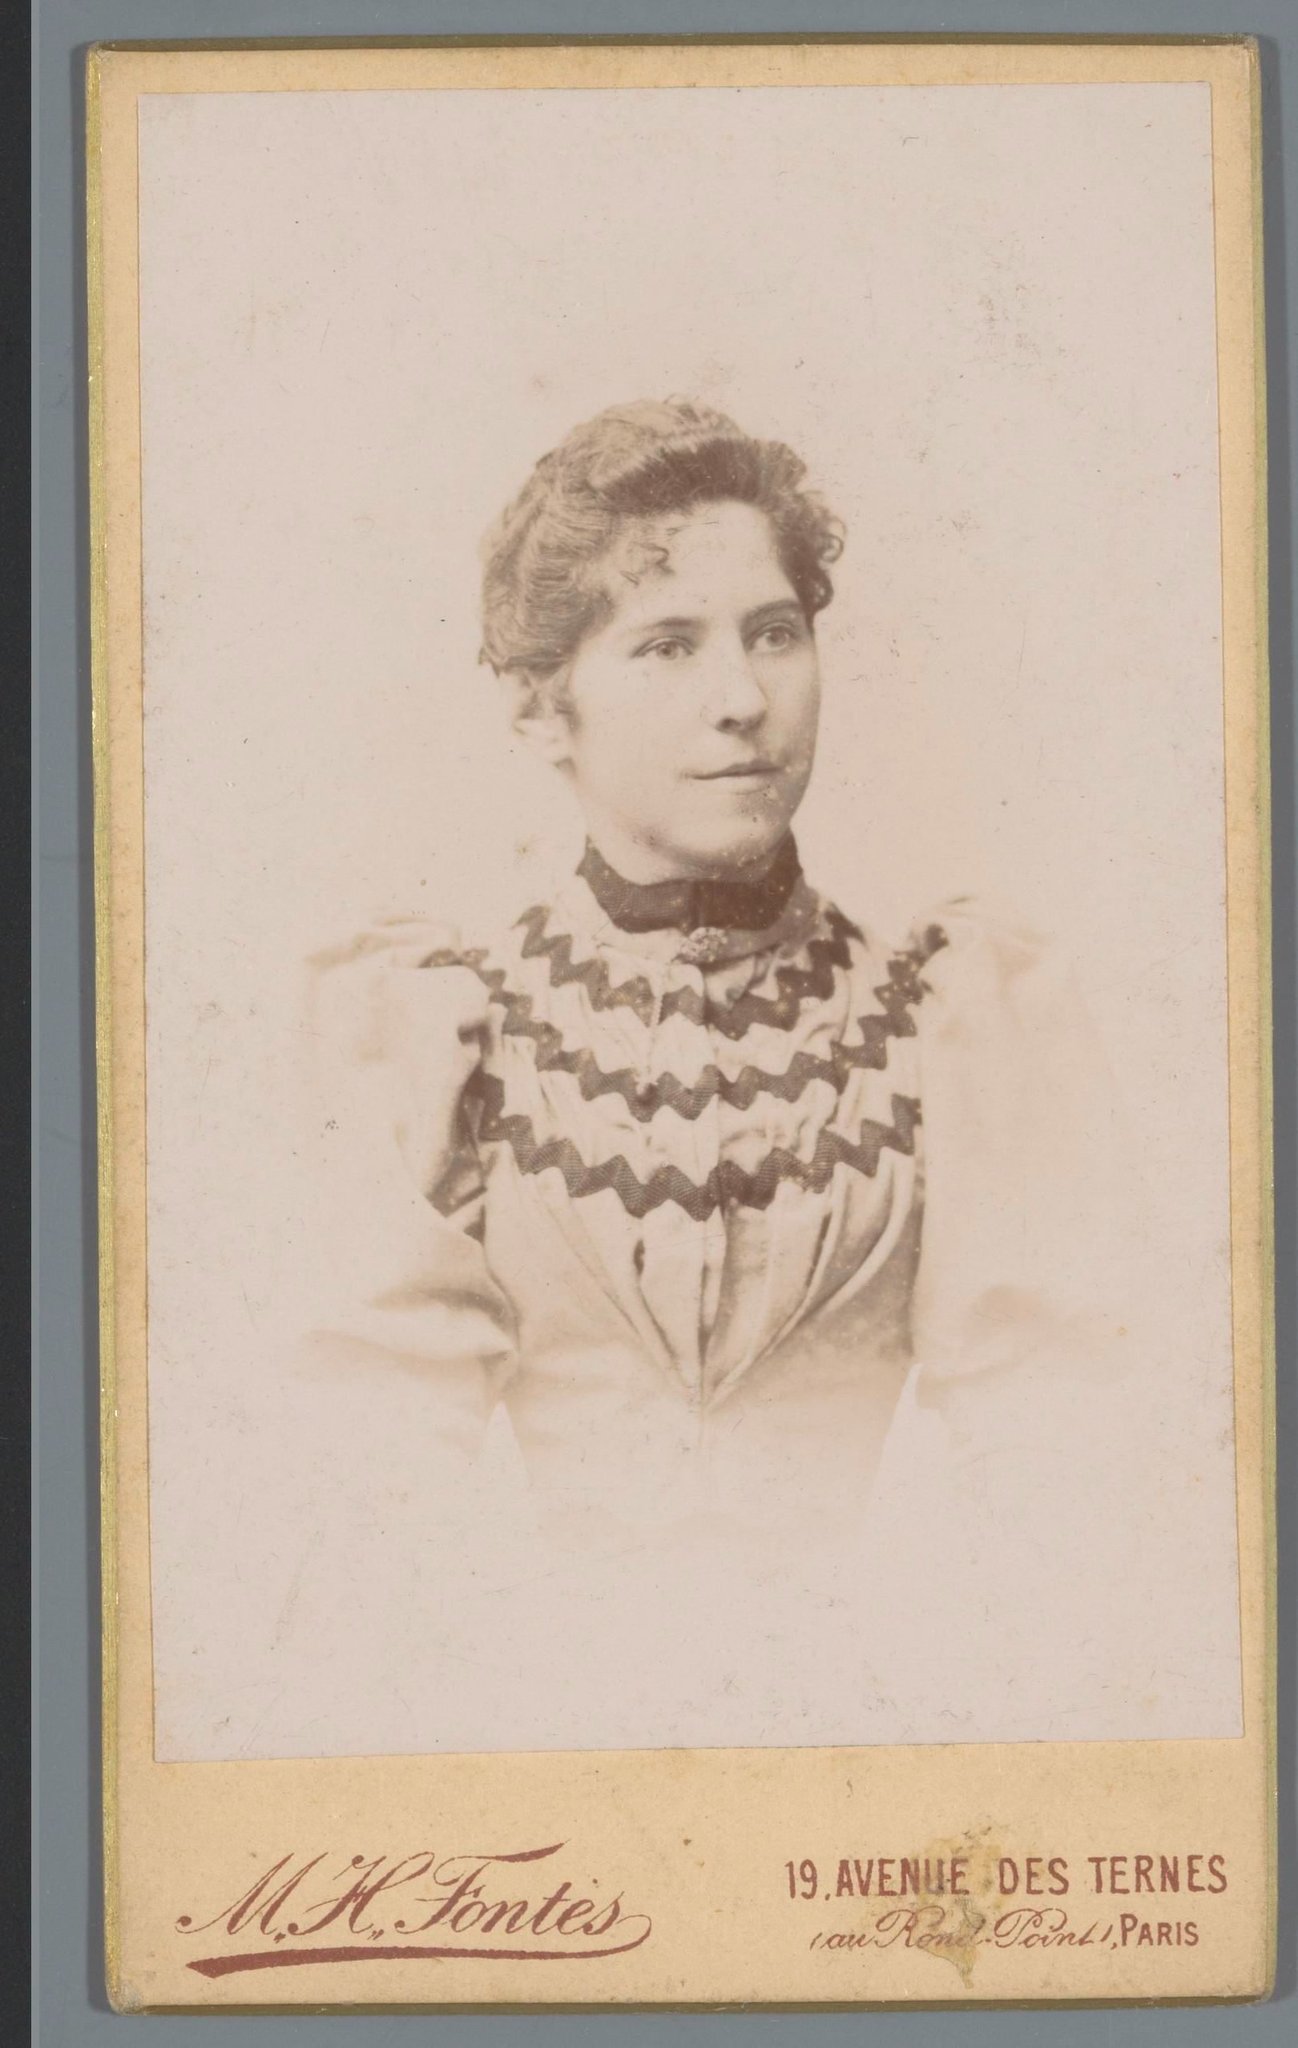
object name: carte de visite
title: Portret van een onbekende vrouw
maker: m.h. fontès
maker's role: fotograaf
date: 1875-1890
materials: paper, cardboard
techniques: collodion silver print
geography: paris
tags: adult woman, anonymous historical person portrayed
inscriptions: address: ‘19, AVENUE DES TERNES/ aux Rond Point, Paris’